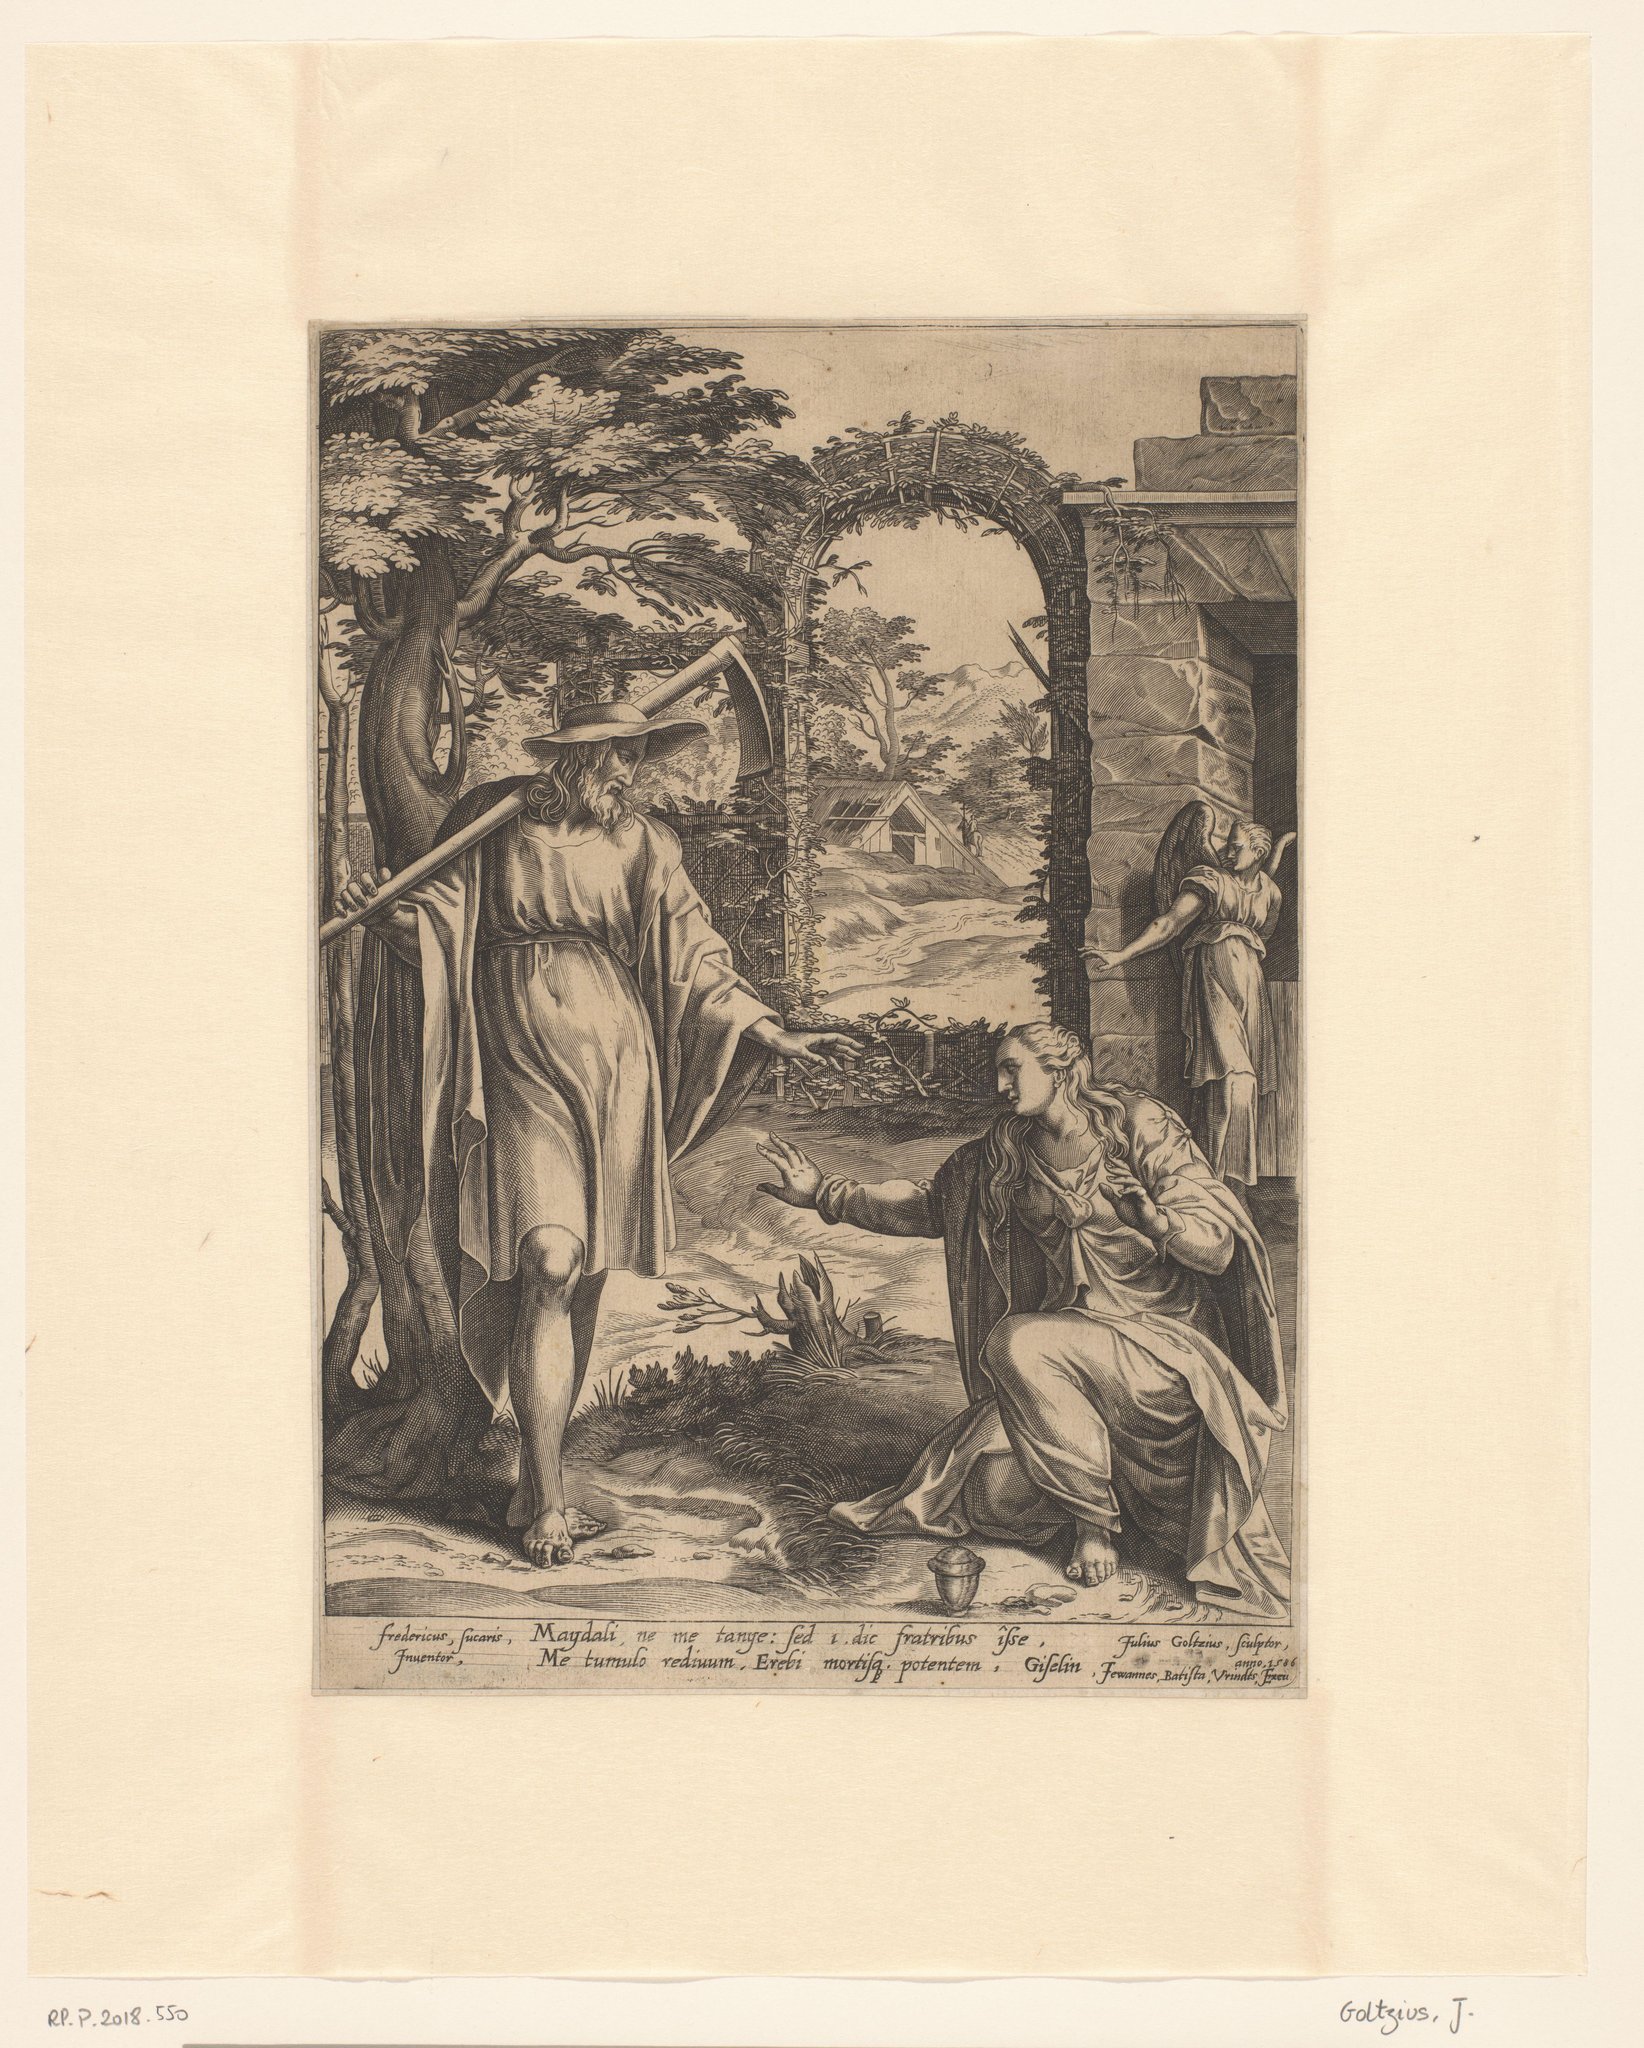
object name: print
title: Noli me tangere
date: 1586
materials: paper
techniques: engraving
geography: antwerp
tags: mary magdalene kneeling before christ, who is usually represented as a gardener with a hoe and/or a spade; 'noli me tangere'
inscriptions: collector's mark: Lugt 2760, collector's mark: Lugt 2228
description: Volgens het opschrift op de prent naar ontwerp van Federico Zuccaro. Volgens de British Museum (zie: V,8.199) naar Giulio Clovio, evenals de bijna identieke prent door Cornelis Cort van 1567. Mogelijk heeft Goltzius naar de prent van Cort gewerkt.